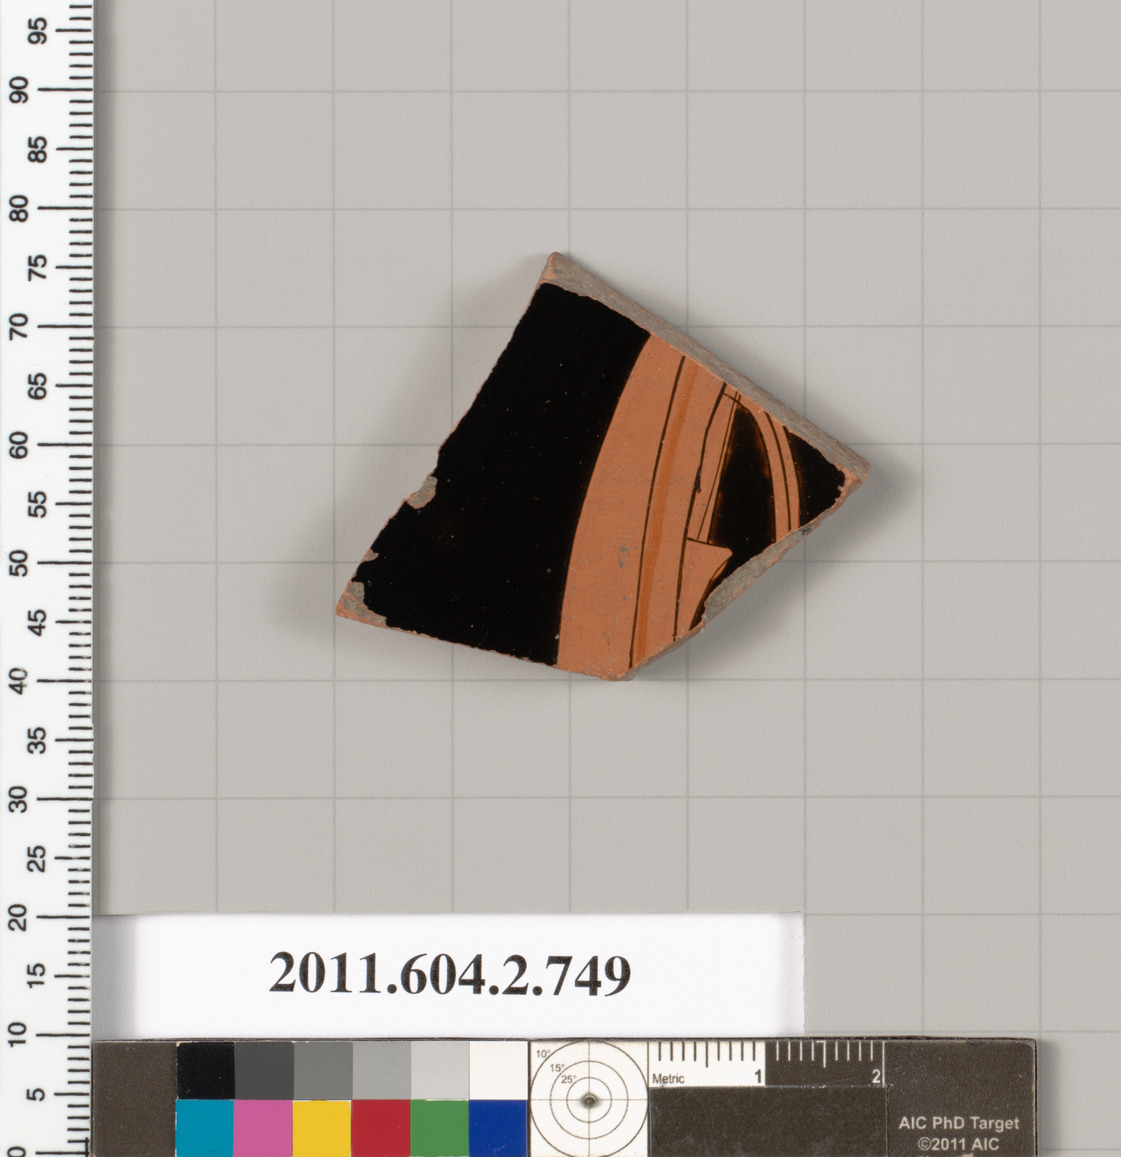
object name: calyx krater fragment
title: Terracotta fragment of a calyx-krater (bowl for mixing wine and water)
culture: greek, attic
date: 475-451 BCE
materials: terracotta